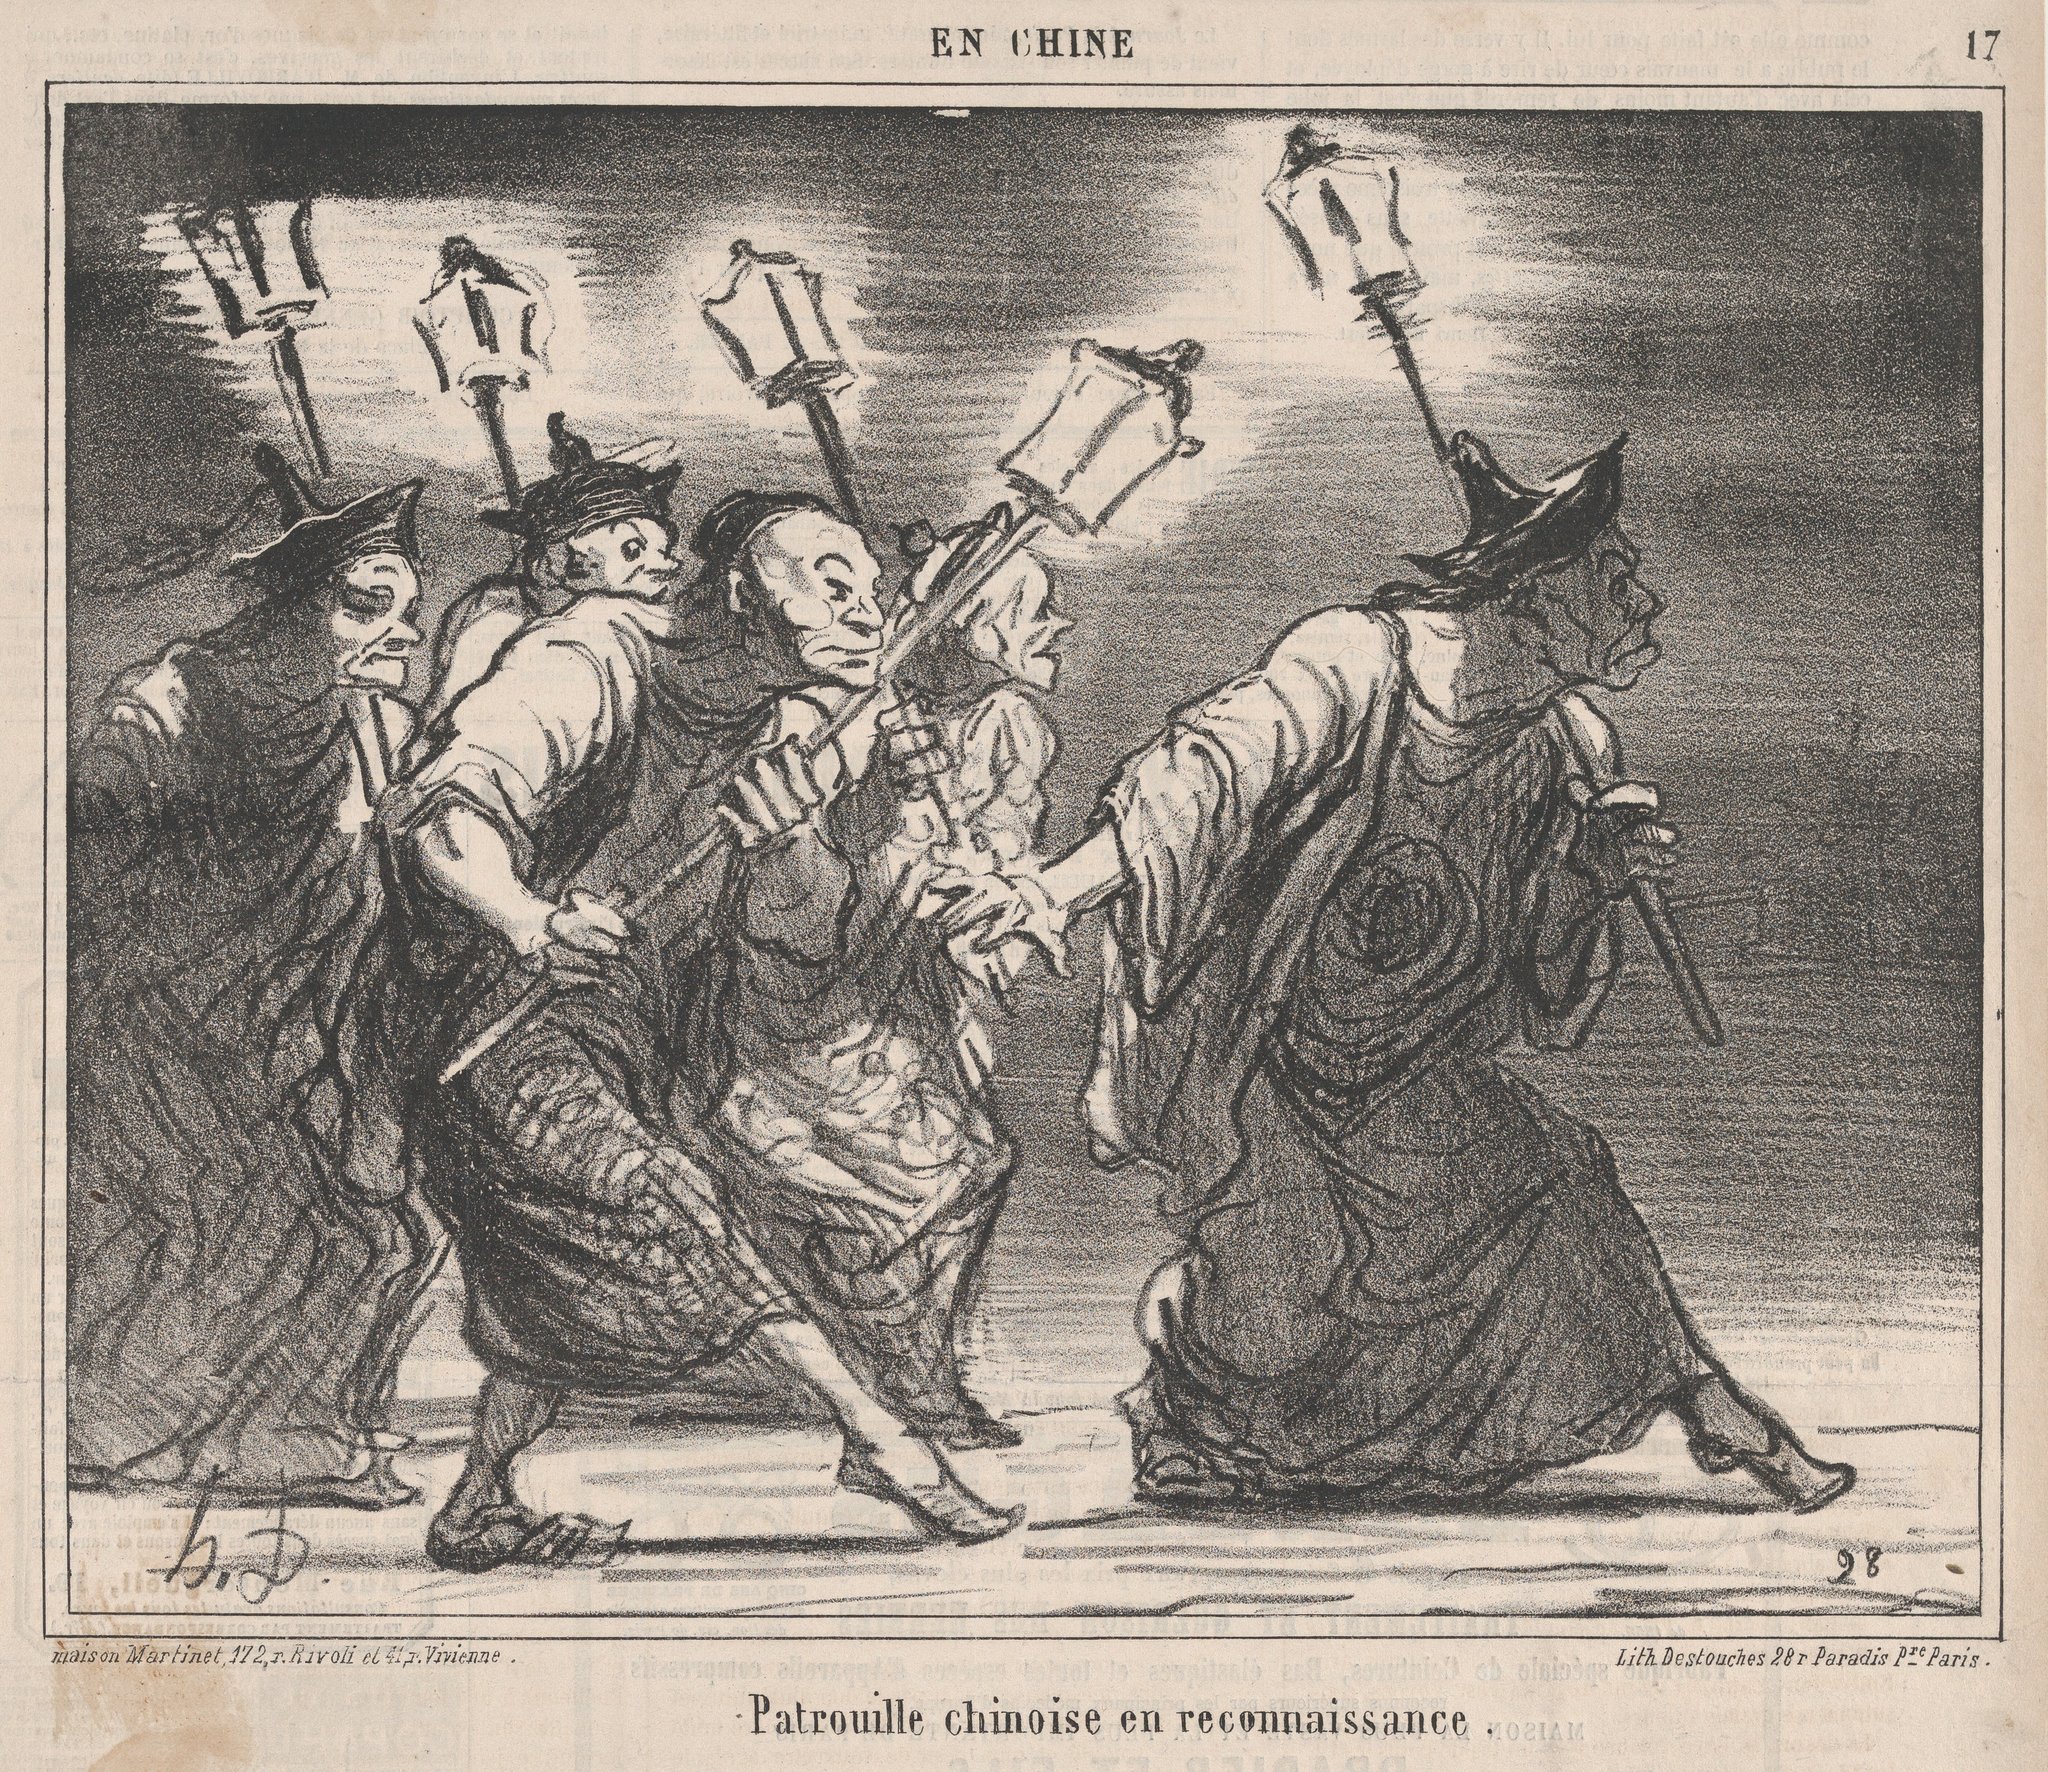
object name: print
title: Patrouille chinoise en reçonnaissance, from En Chine, published in Le Charivari, November 7, 1859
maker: honoré daumier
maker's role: artist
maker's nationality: french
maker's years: 1808-1879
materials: paper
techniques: lithograph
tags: satire,men